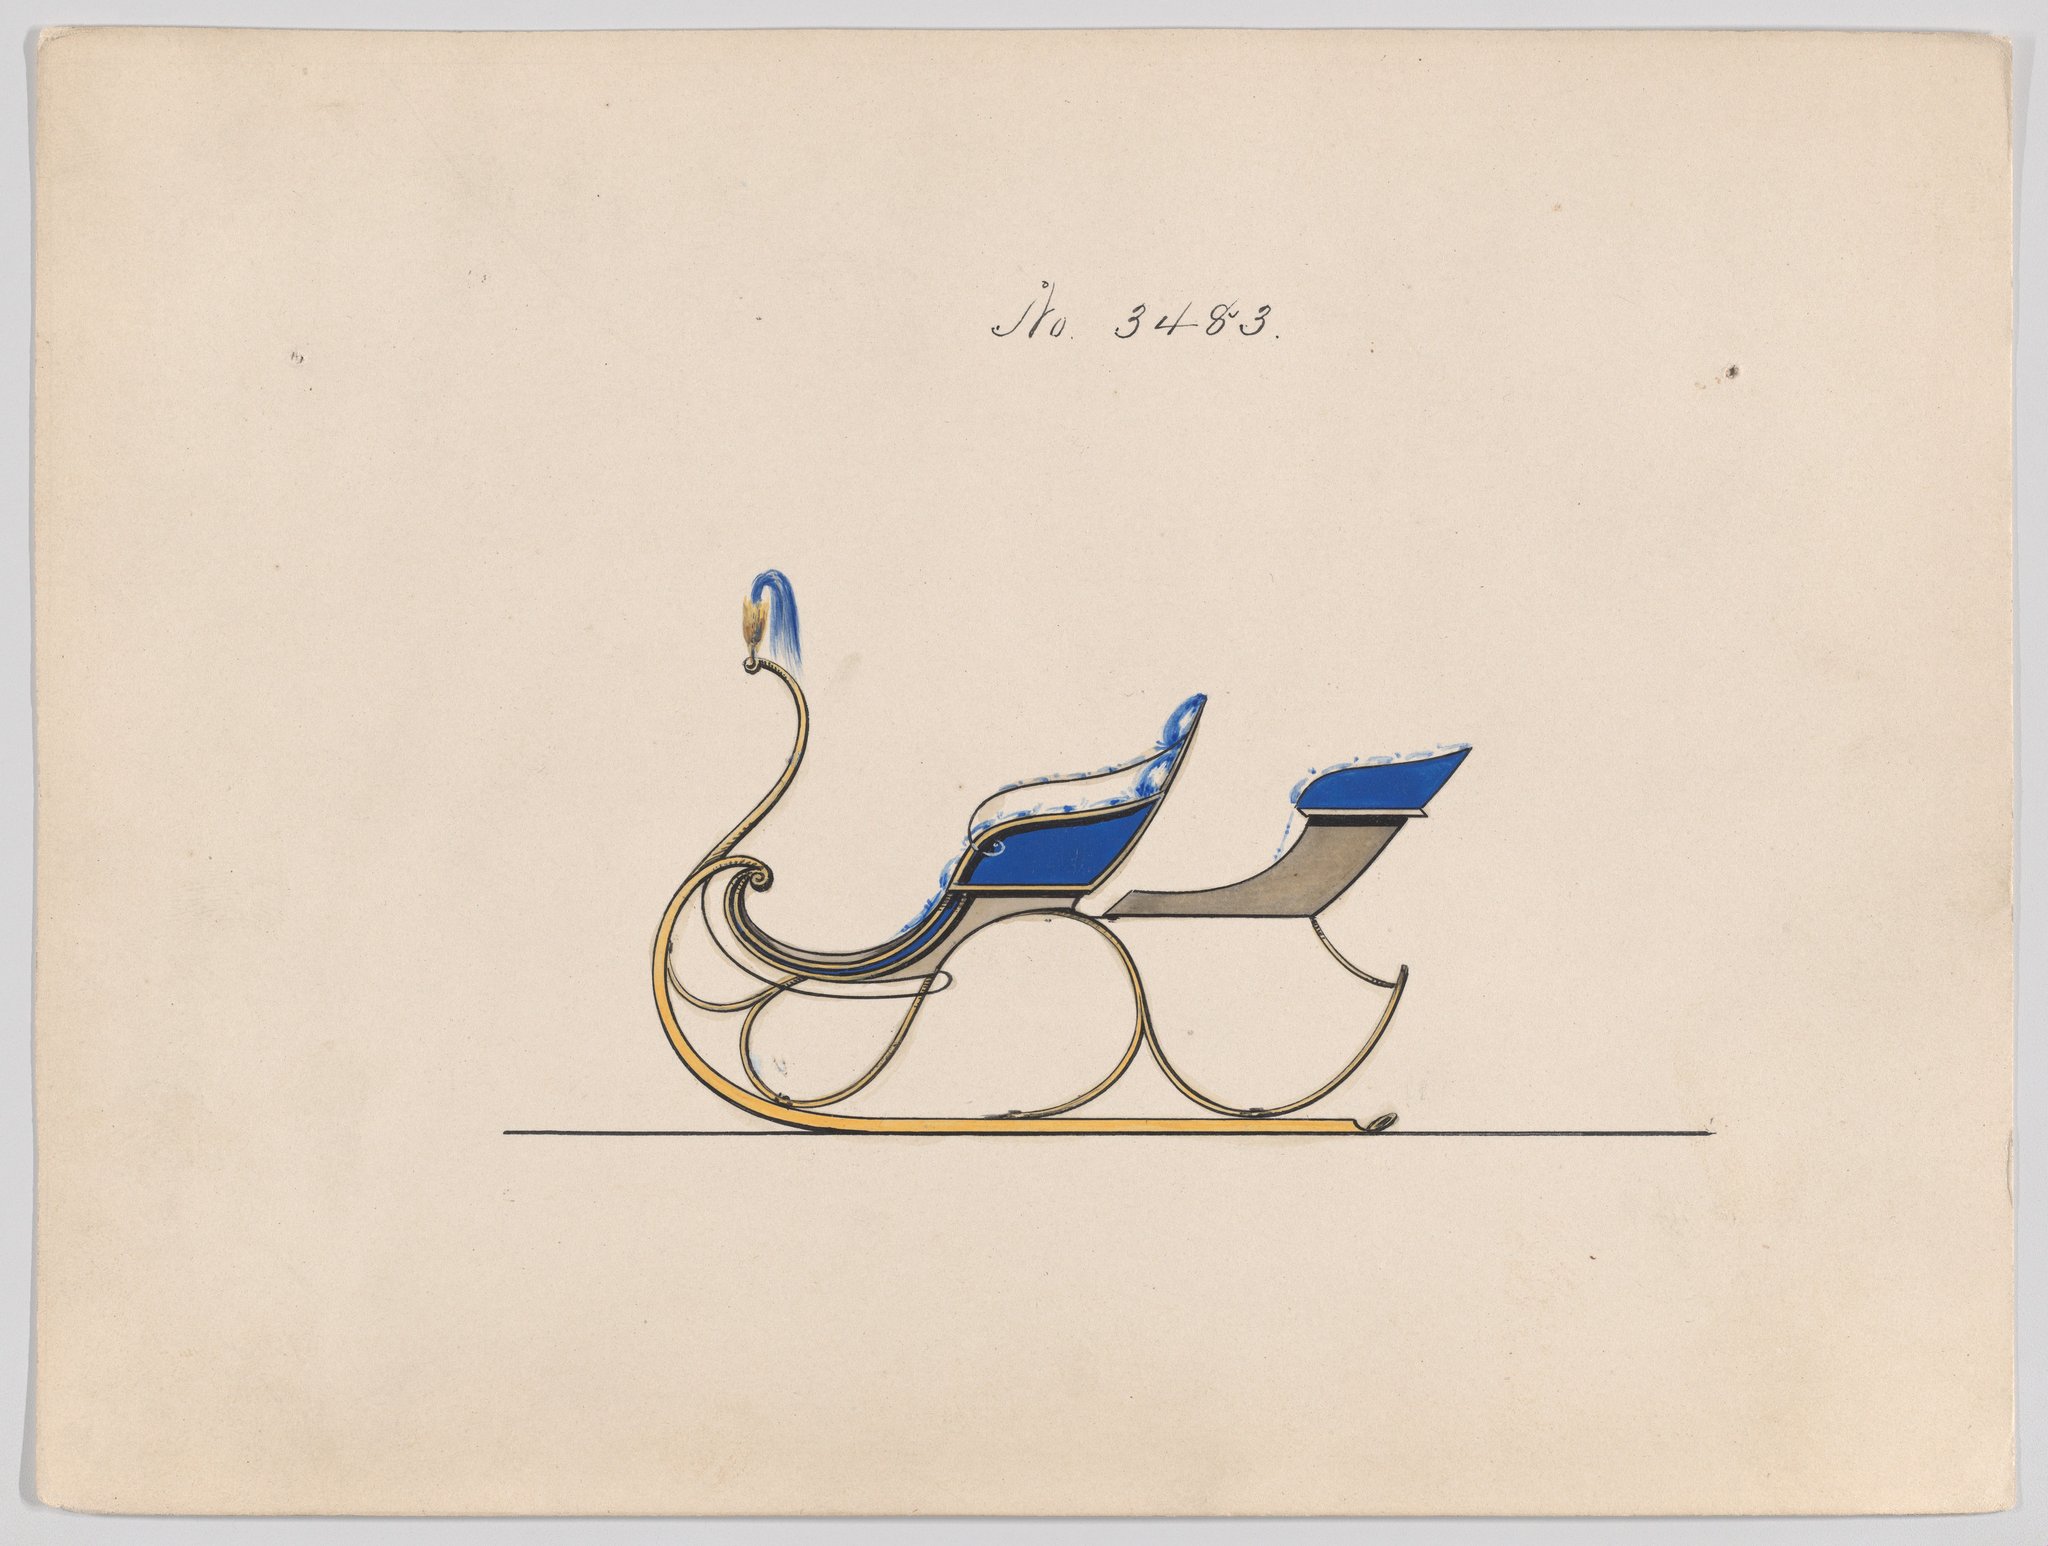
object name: drawing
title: Sleigh with Rumble Seat #3483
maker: brewster & co.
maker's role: manufacturer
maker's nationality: american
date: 1879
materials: gouache, gum arabic, ink, watercolor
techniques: pen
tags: sleighs